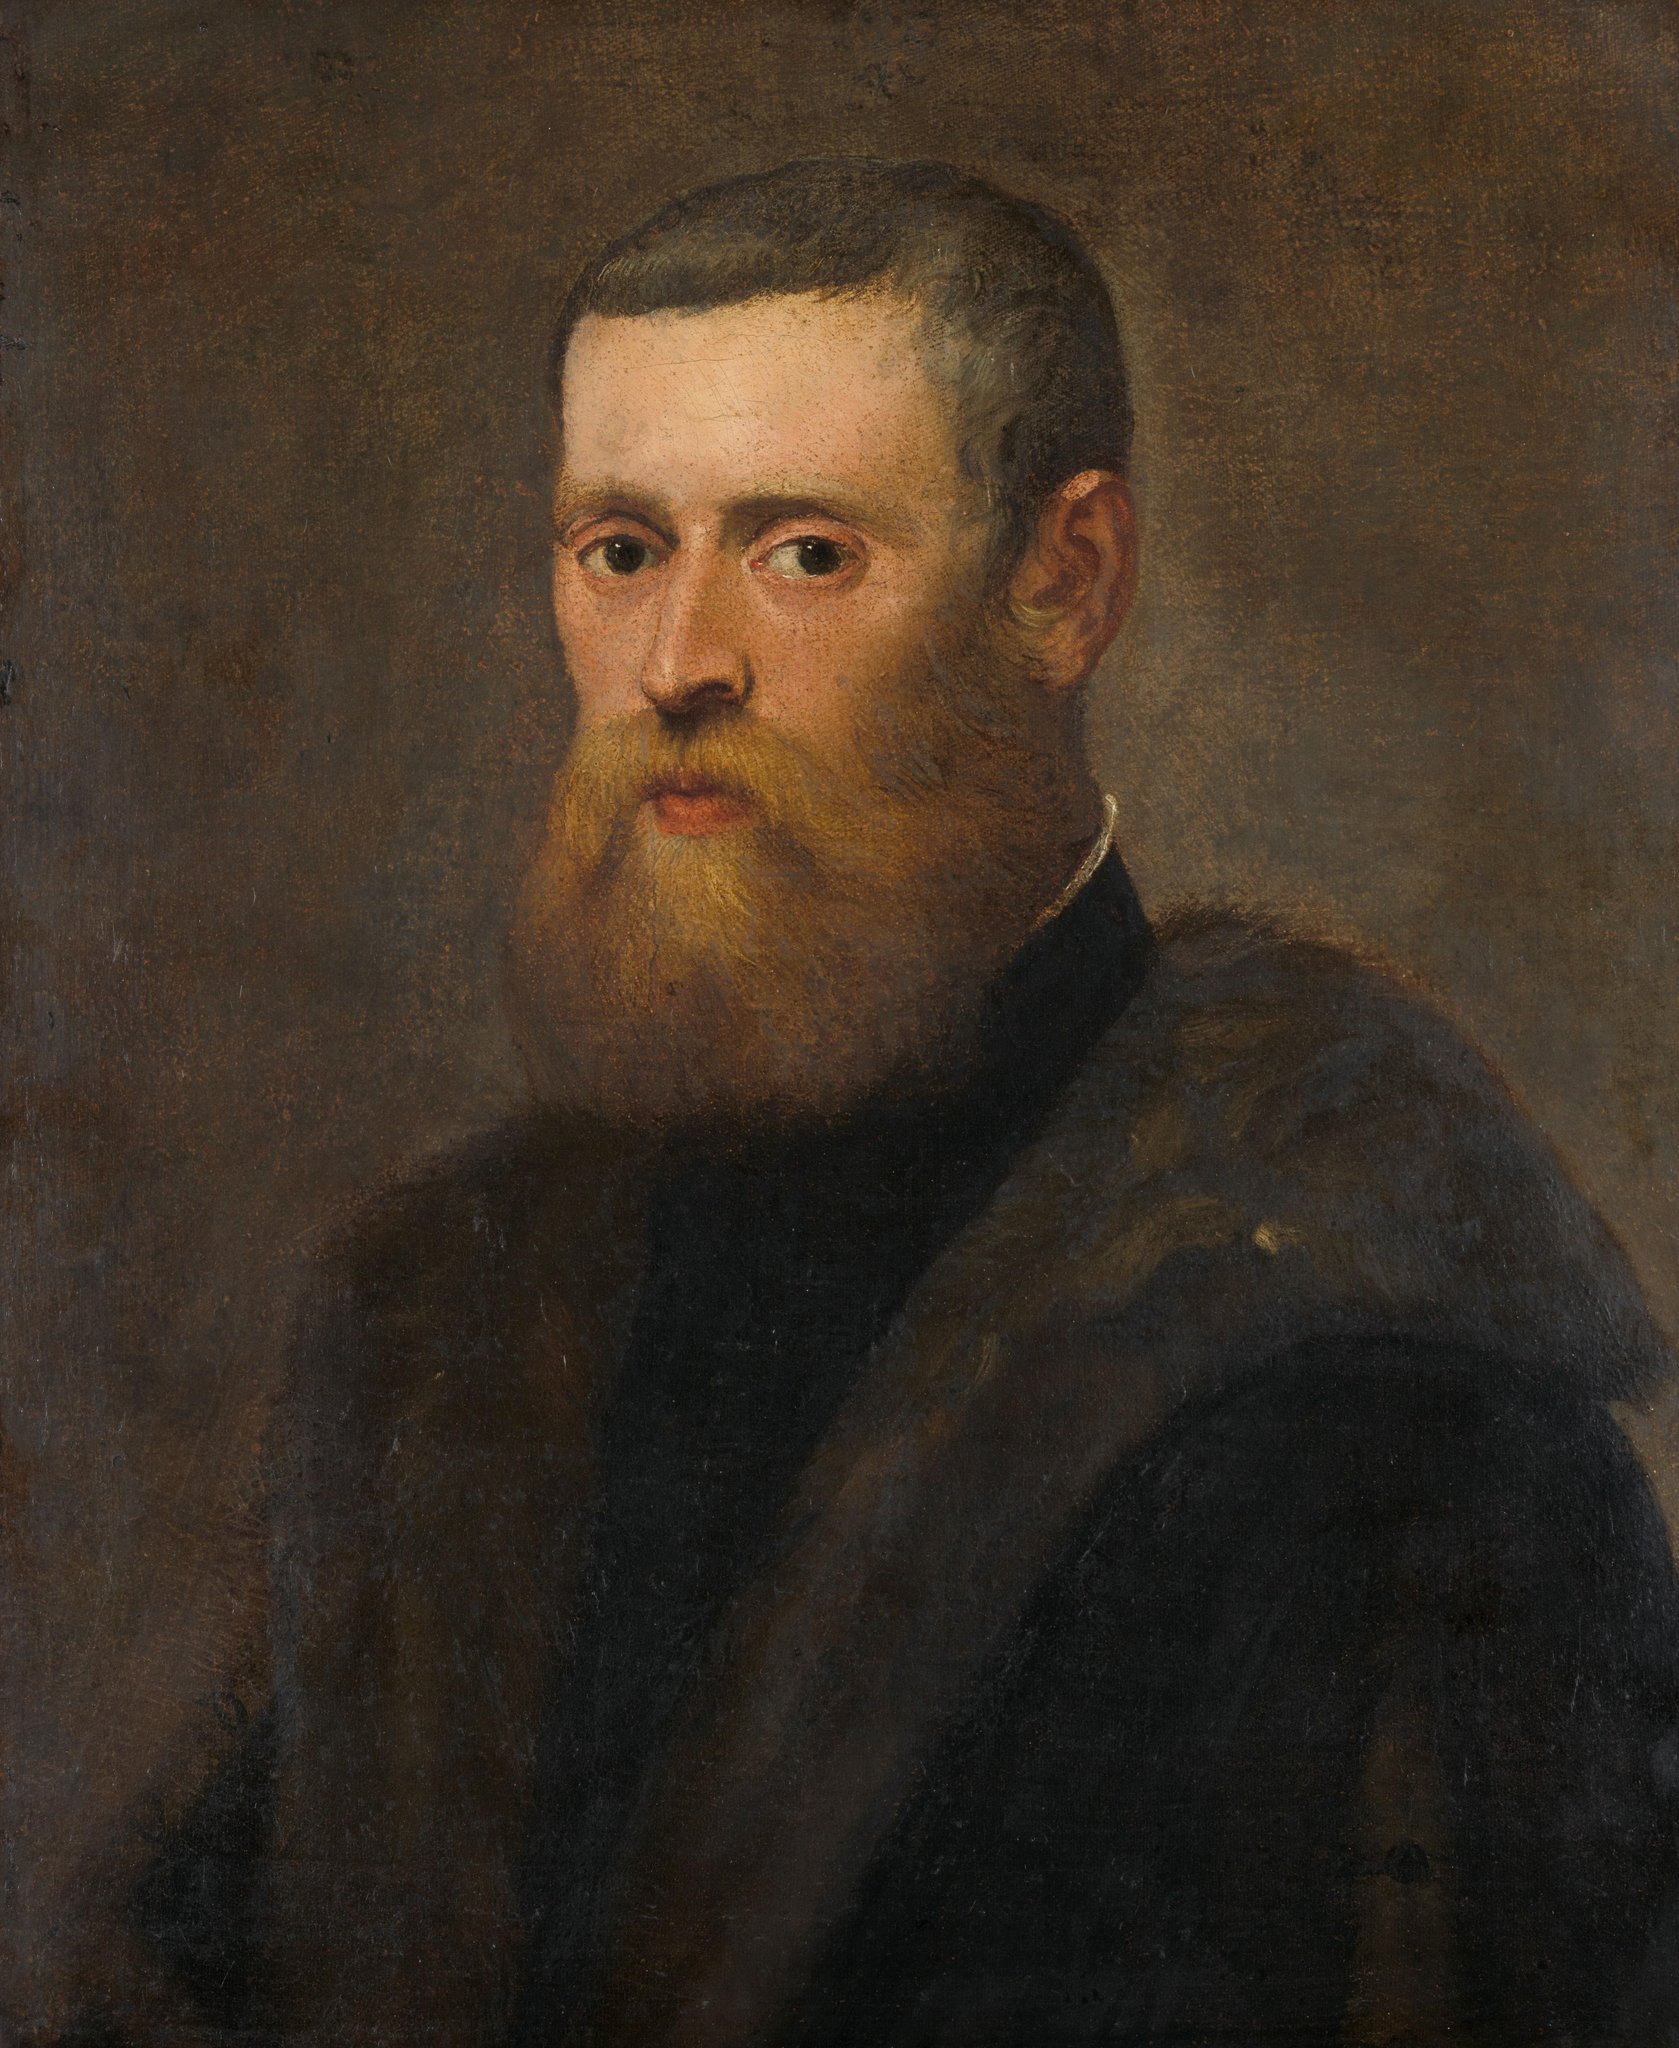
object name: painting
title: Portrait of a Man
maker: jacopo tintoretto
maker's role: draughtsman, painter, print maker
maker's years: 1519-1594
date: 1550-1575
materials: canvas, oil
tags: anonymous historical person portrayed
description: Portret van een man met een korte baard en een met bont afgezette mantel, buste naar links.